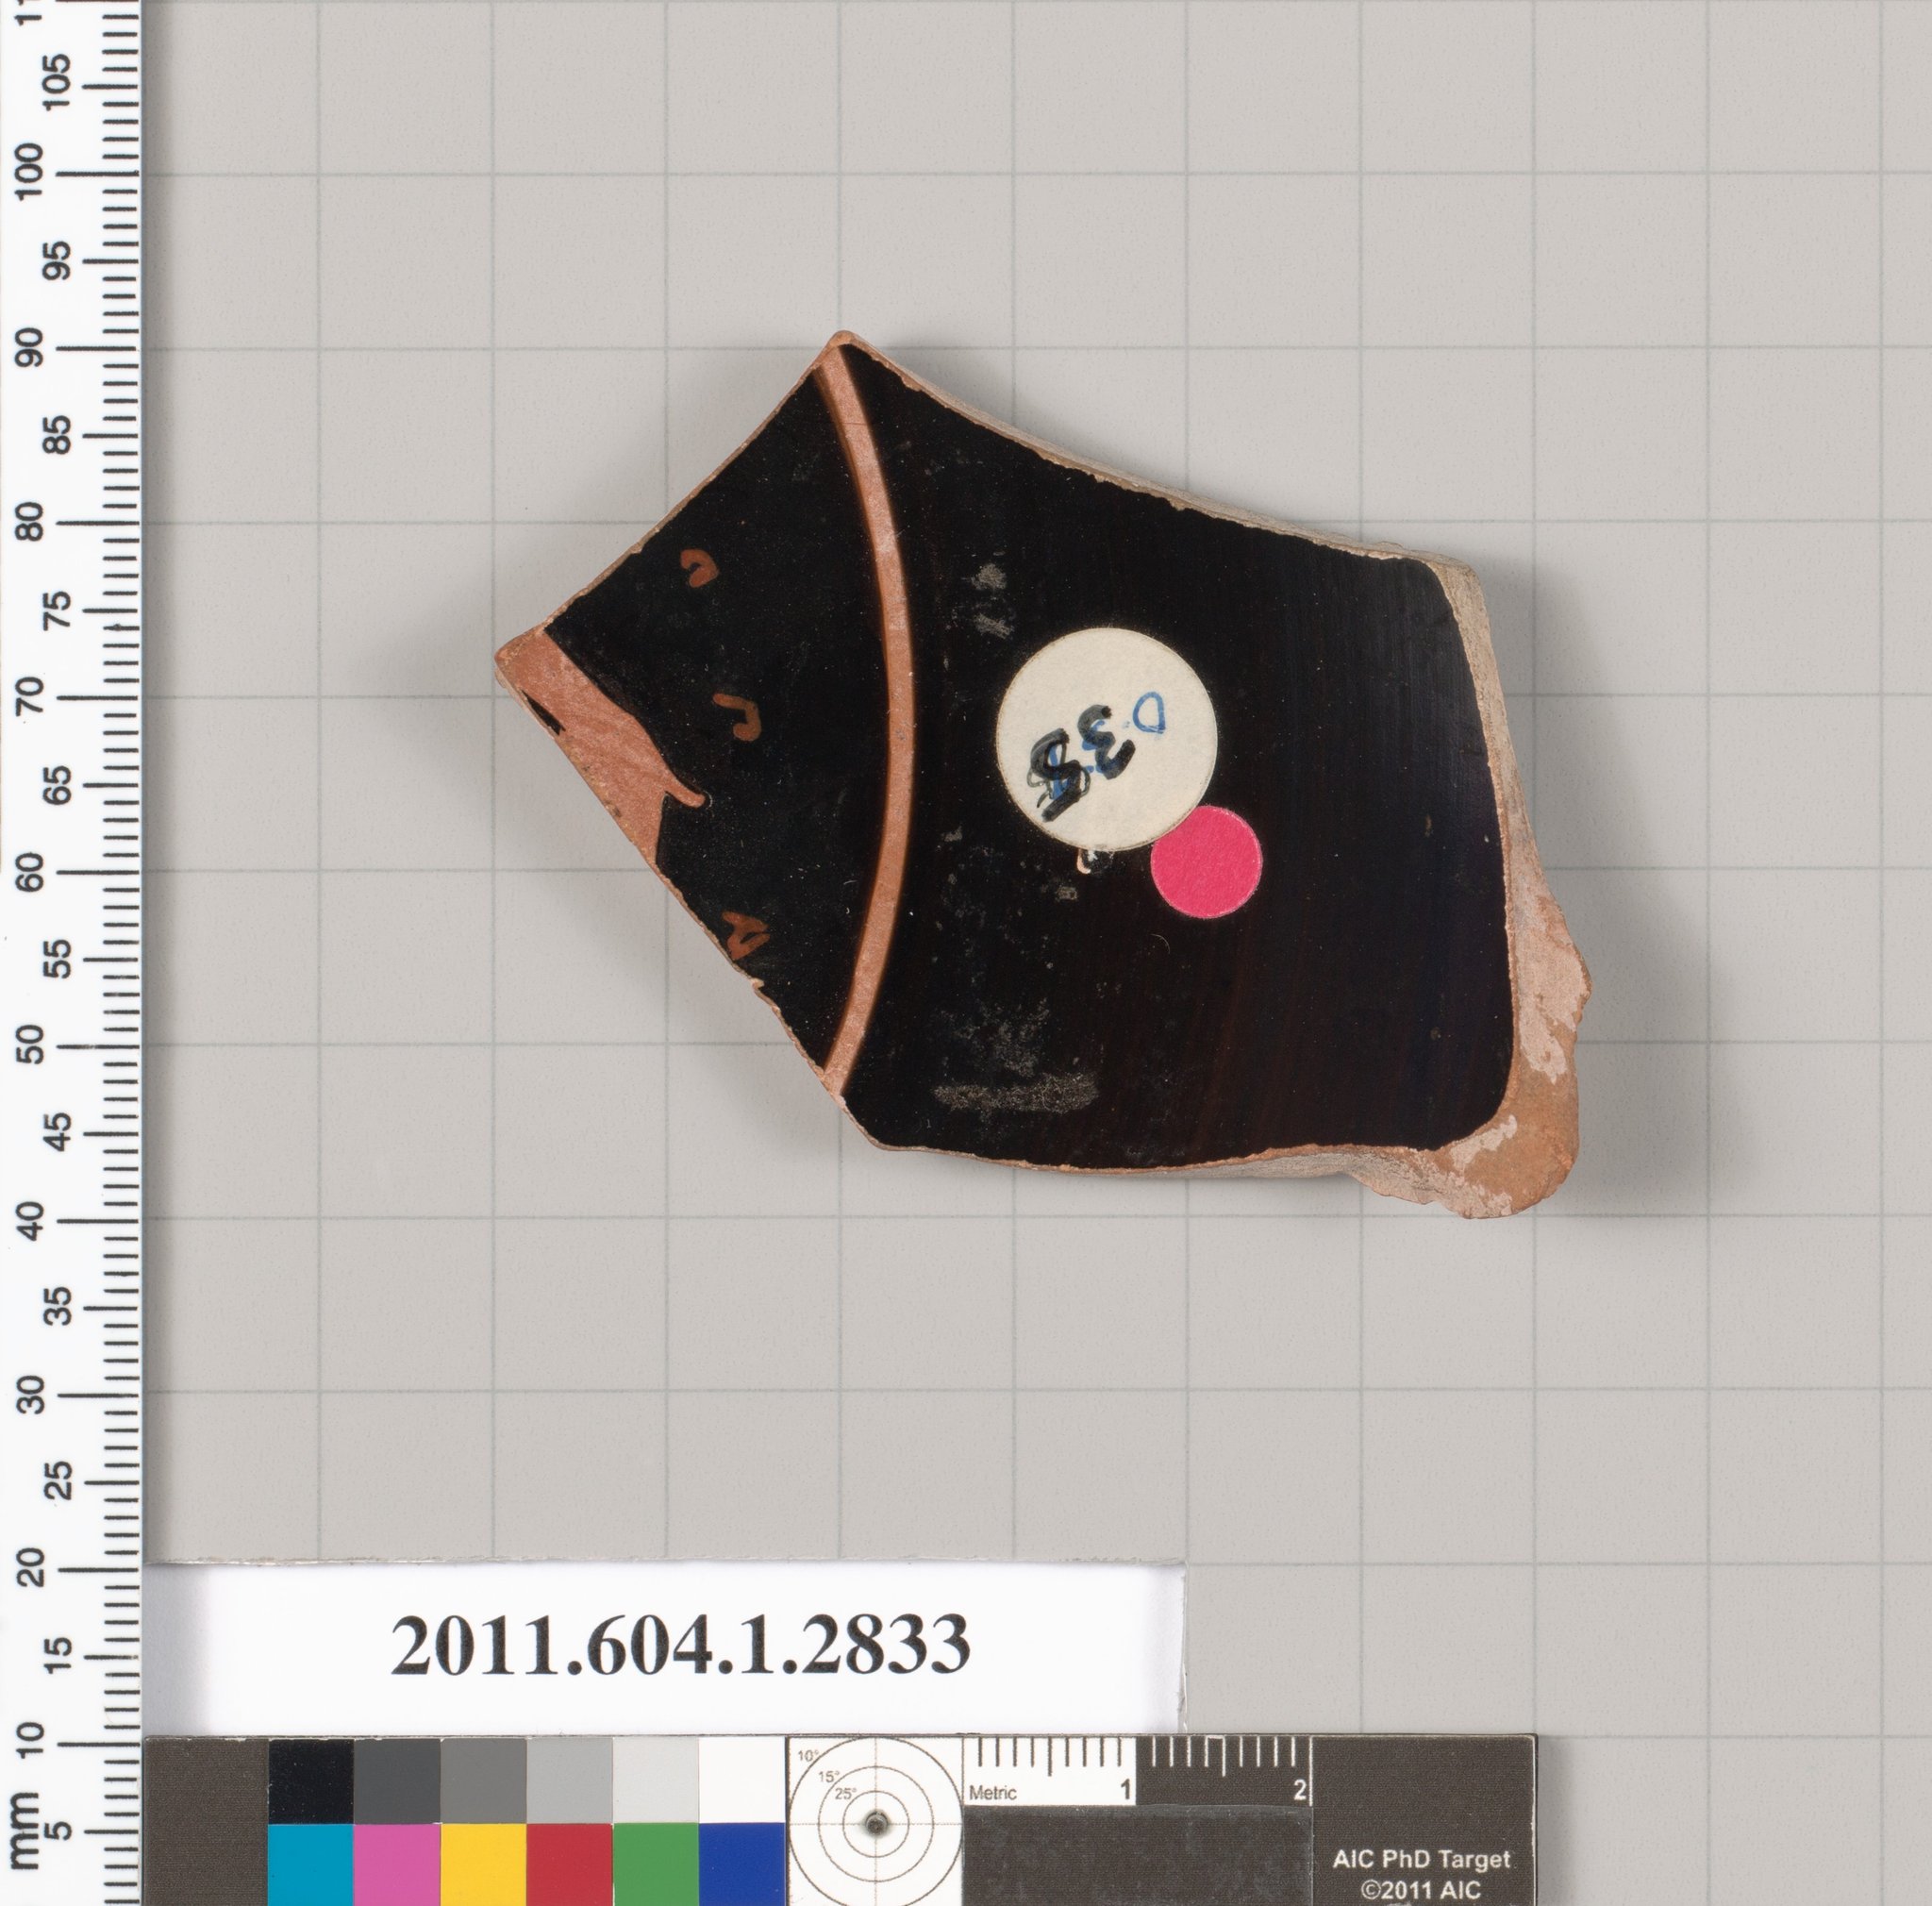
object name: kylix fragment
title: Terracotta fragment of a kylix (drinking cup)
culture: greek, attic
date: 520-500 BCE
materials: terracotta